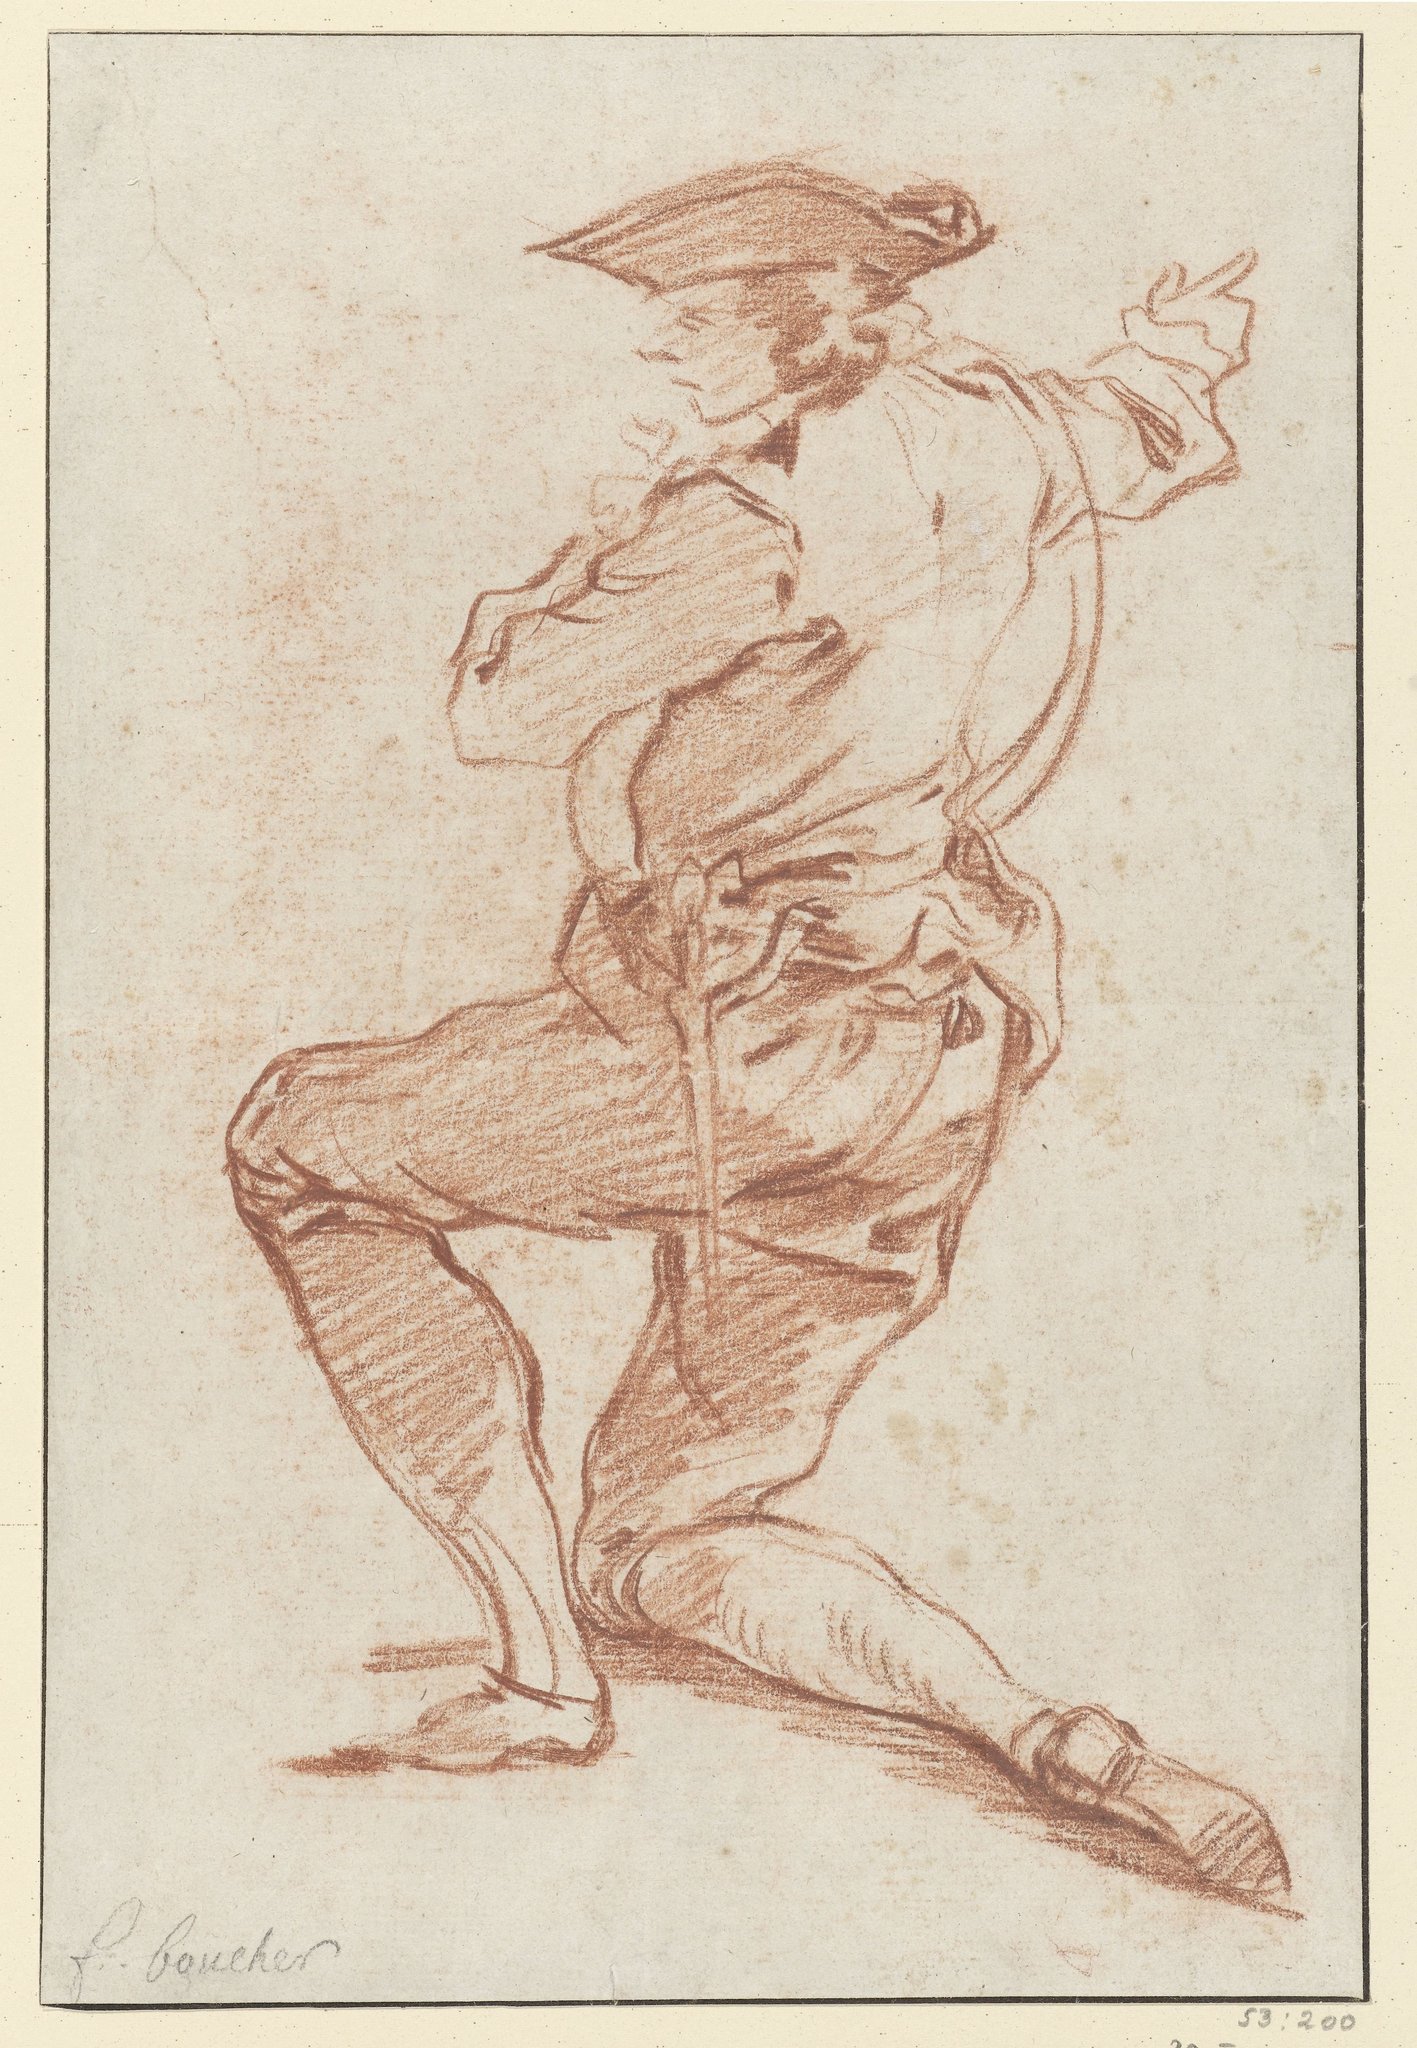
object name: drawing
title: Study of a kneeling huntman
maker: françois boucher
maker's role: draughtsman, print maker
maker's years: 1703-1770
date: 1713-1734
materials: chalk, paper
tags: hunter, literary characters and objects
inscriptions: signature, recto, lower left, pencil: ‘f. boucher’